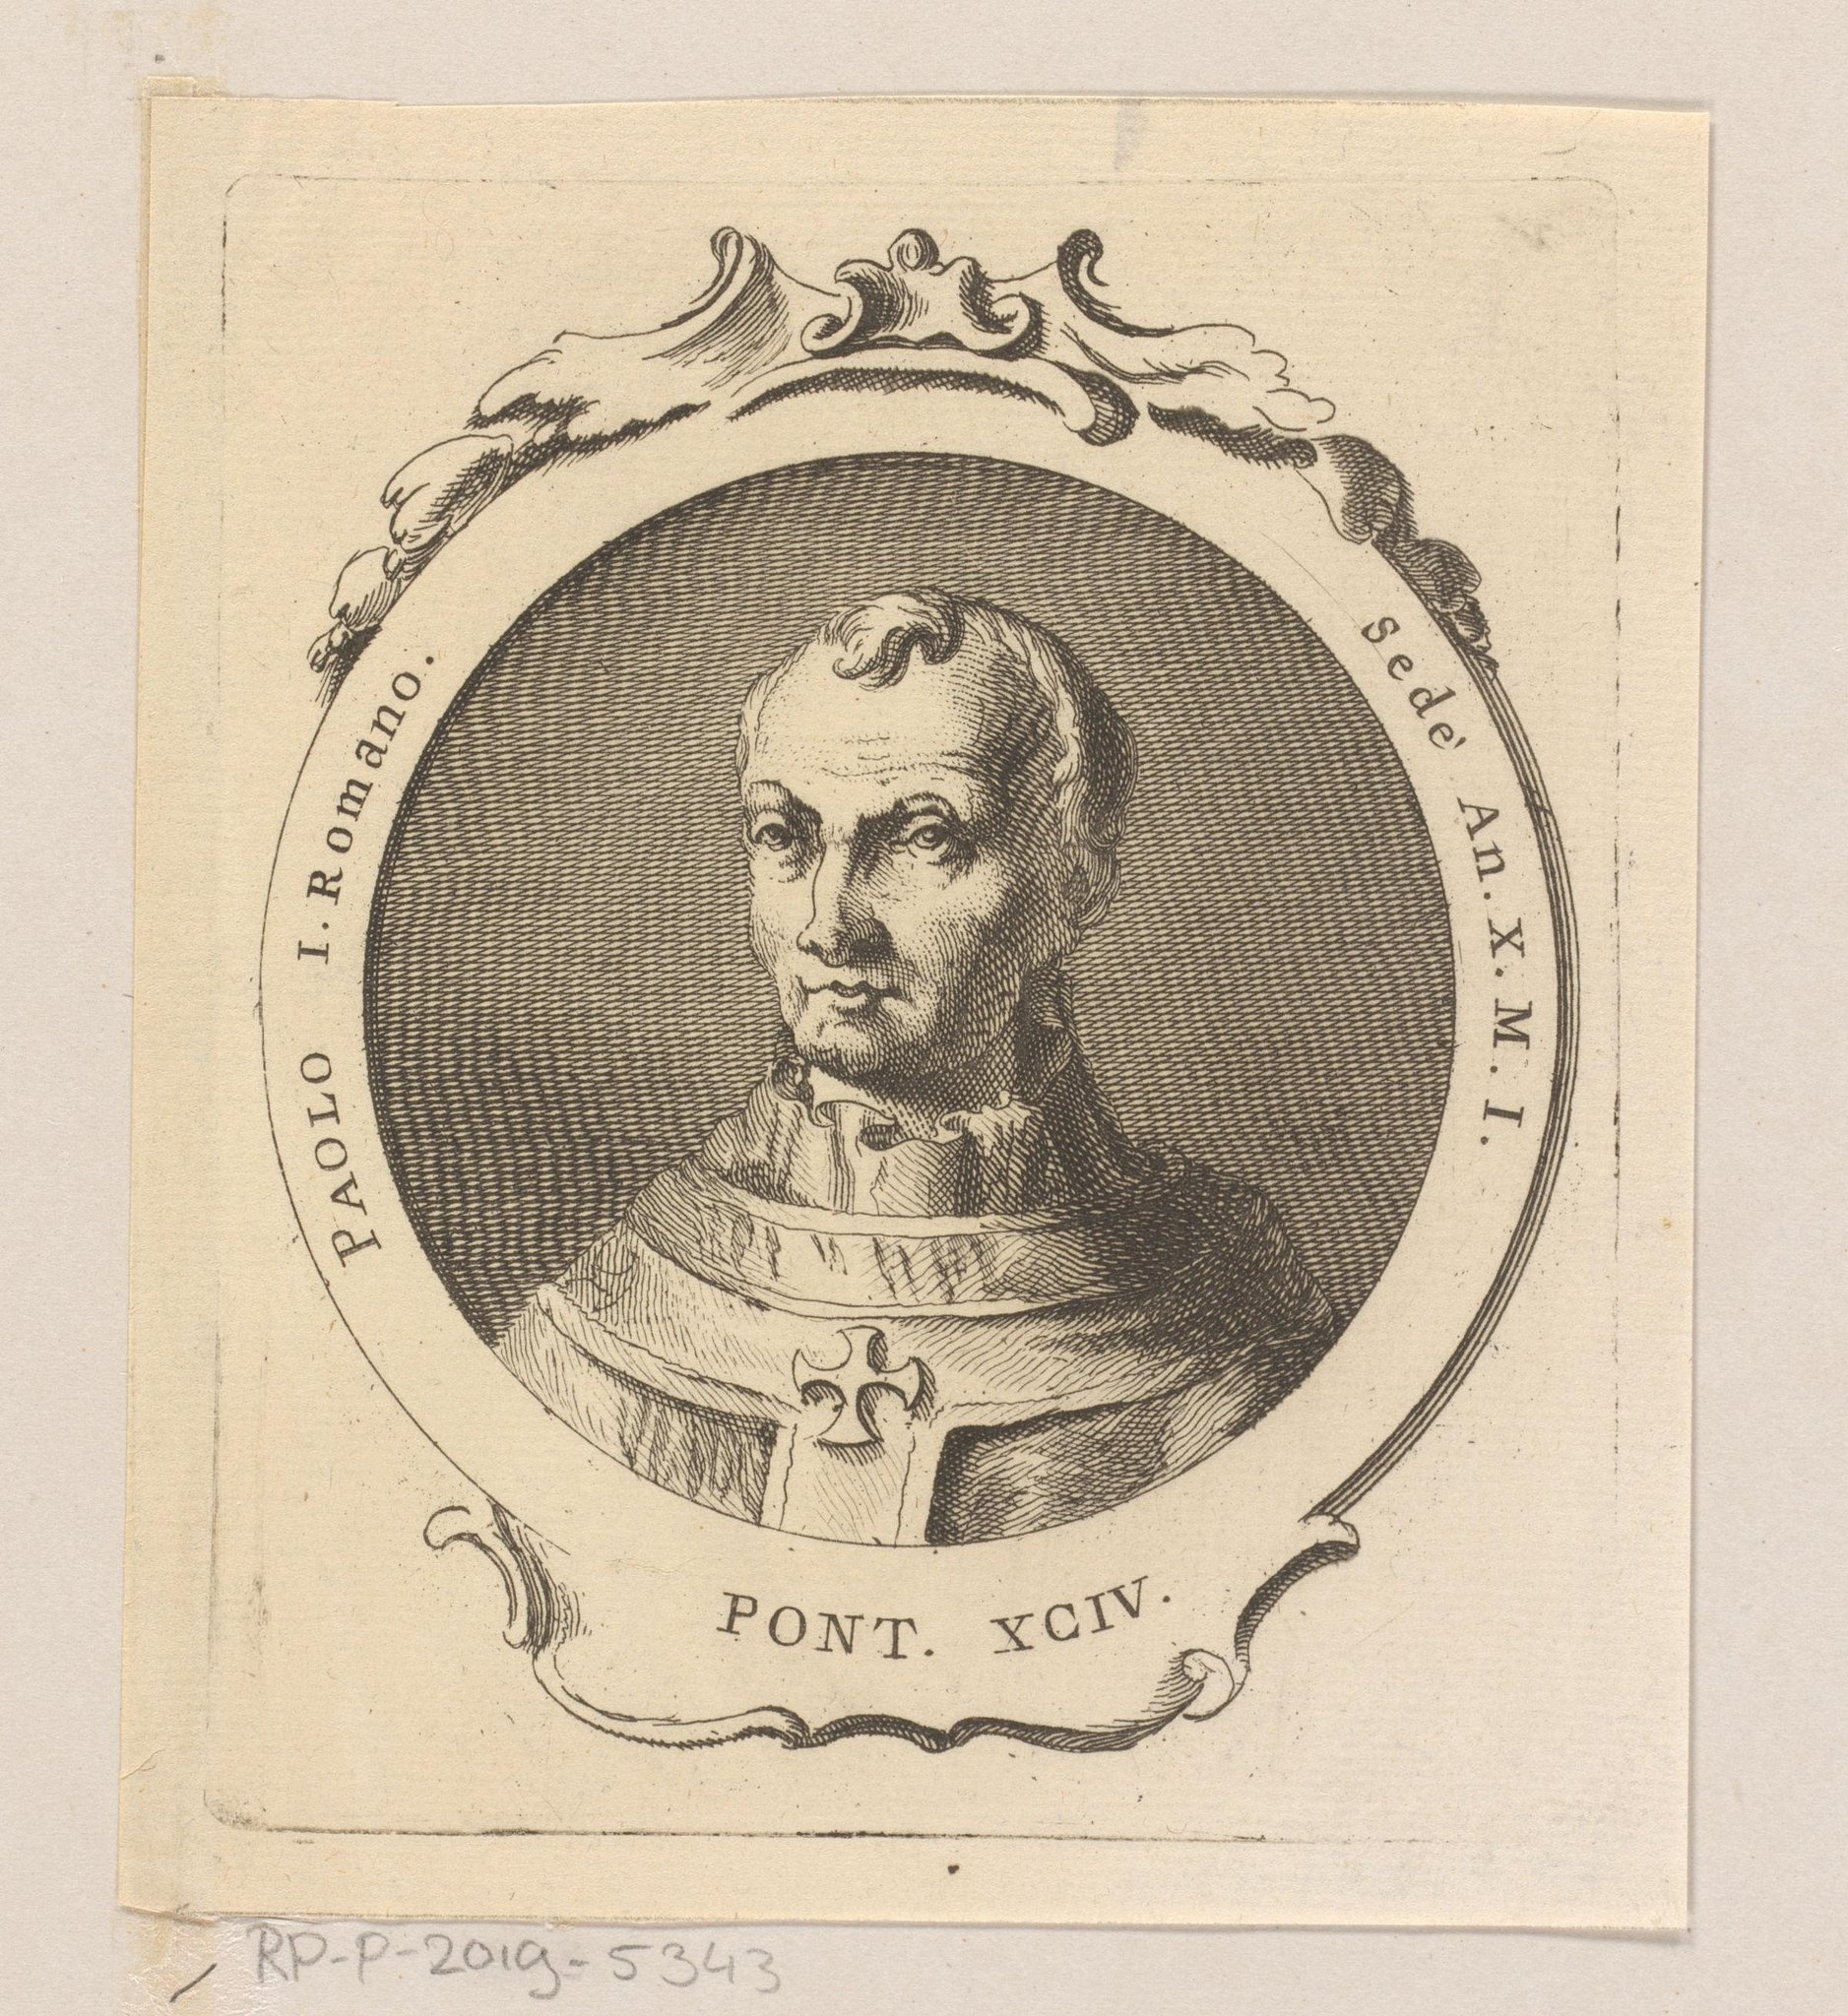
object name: print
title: Paolo I Romano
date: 1775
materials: paper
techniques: engraving, etching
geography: venice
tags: rome, historical persons, pope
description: Prent uit: Effigies Romanorum pontificum a S. Petro ad Pium VI. feliciter regnantem (...). 2 dln. Venetië en Bassano del Grappa: Giuseppe Remondini, 1775.